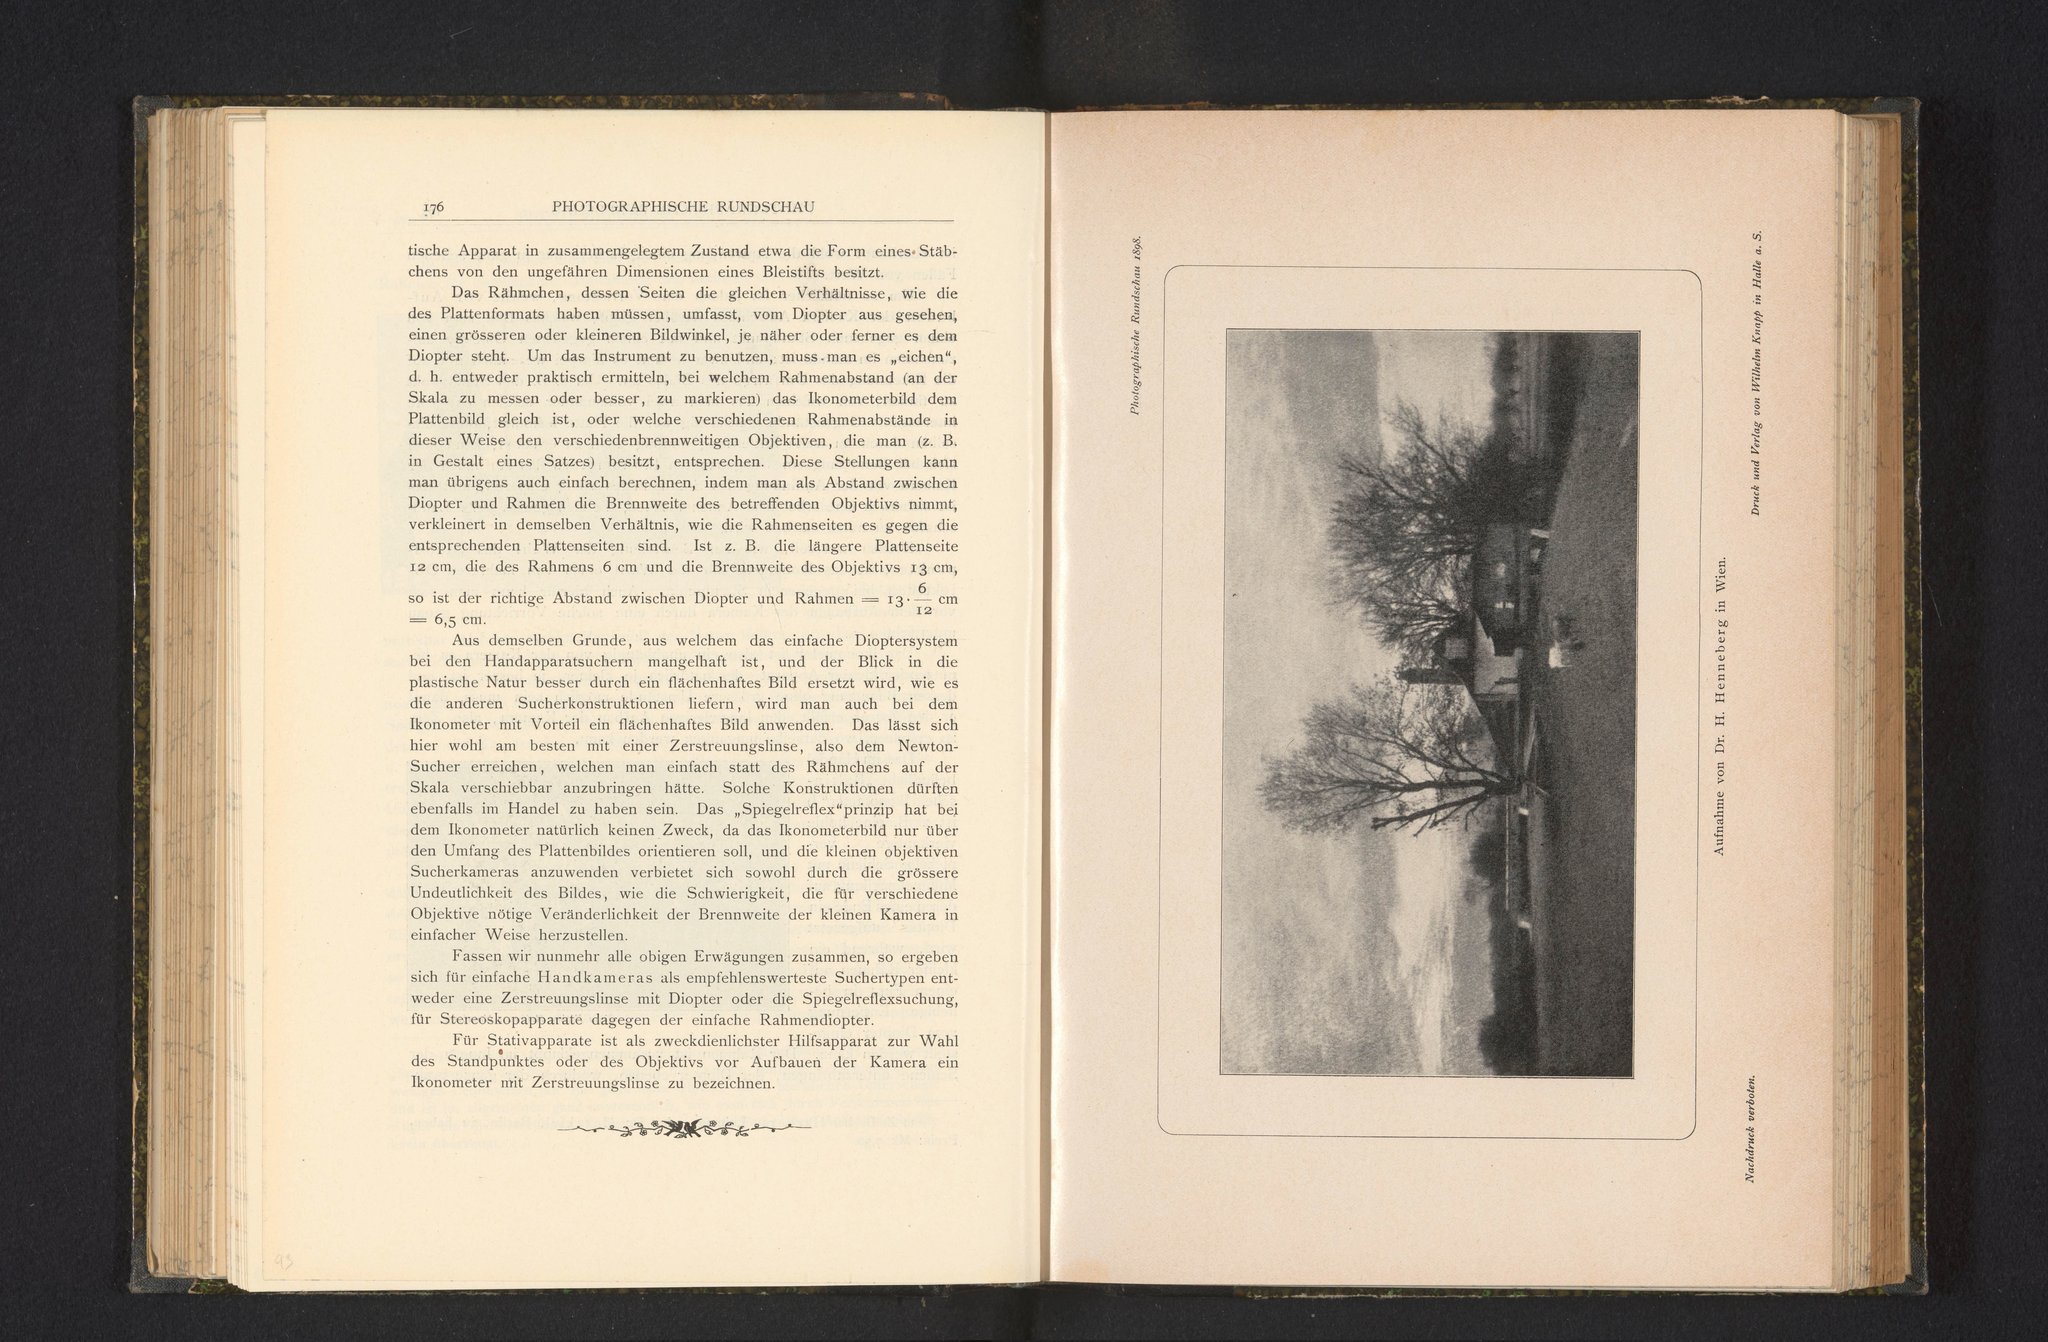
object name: page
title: Exterieur van een boerderij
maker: hugo henneberg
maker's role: fotograaf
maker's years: 1863-1918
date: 1893-1898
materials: paper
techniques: autotype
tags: farmers, façade (of house or building)